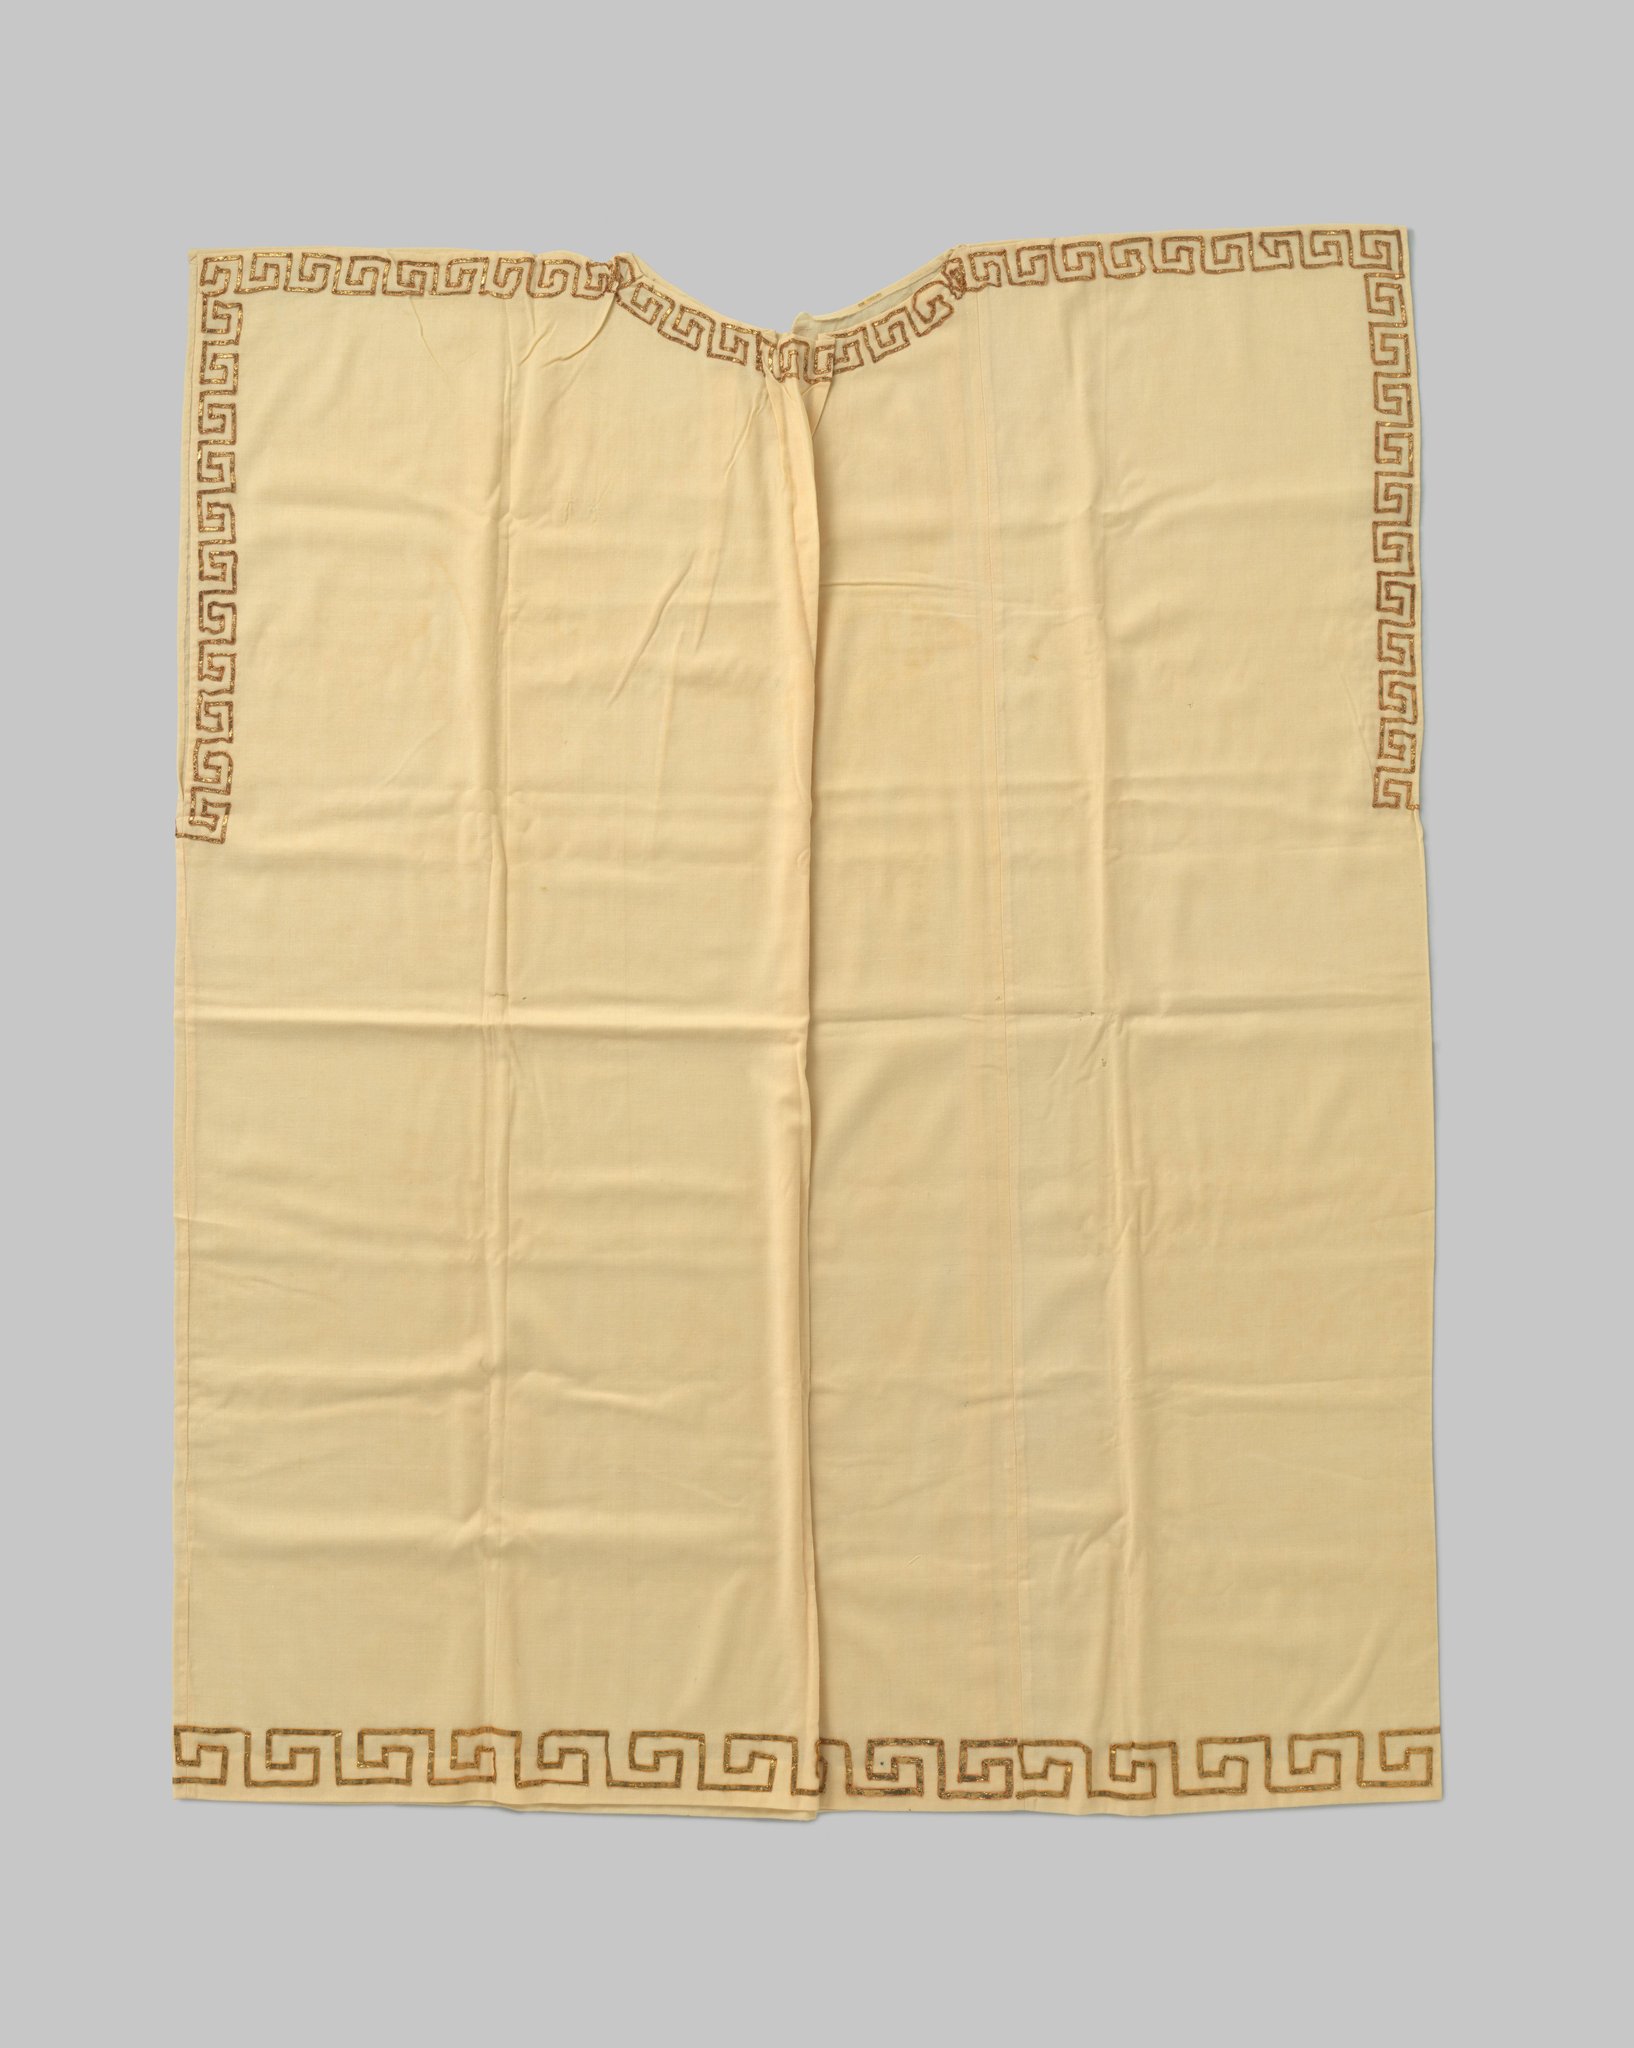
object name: costume component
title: Kledingonderdeel van Sinterklaas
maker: Anonymous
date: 1800-1900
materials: wool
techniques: weave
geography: europe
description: Aan de randen is het kledingstuk van beige wol afgezet met een goudkleurig opgestikt meandermotief.